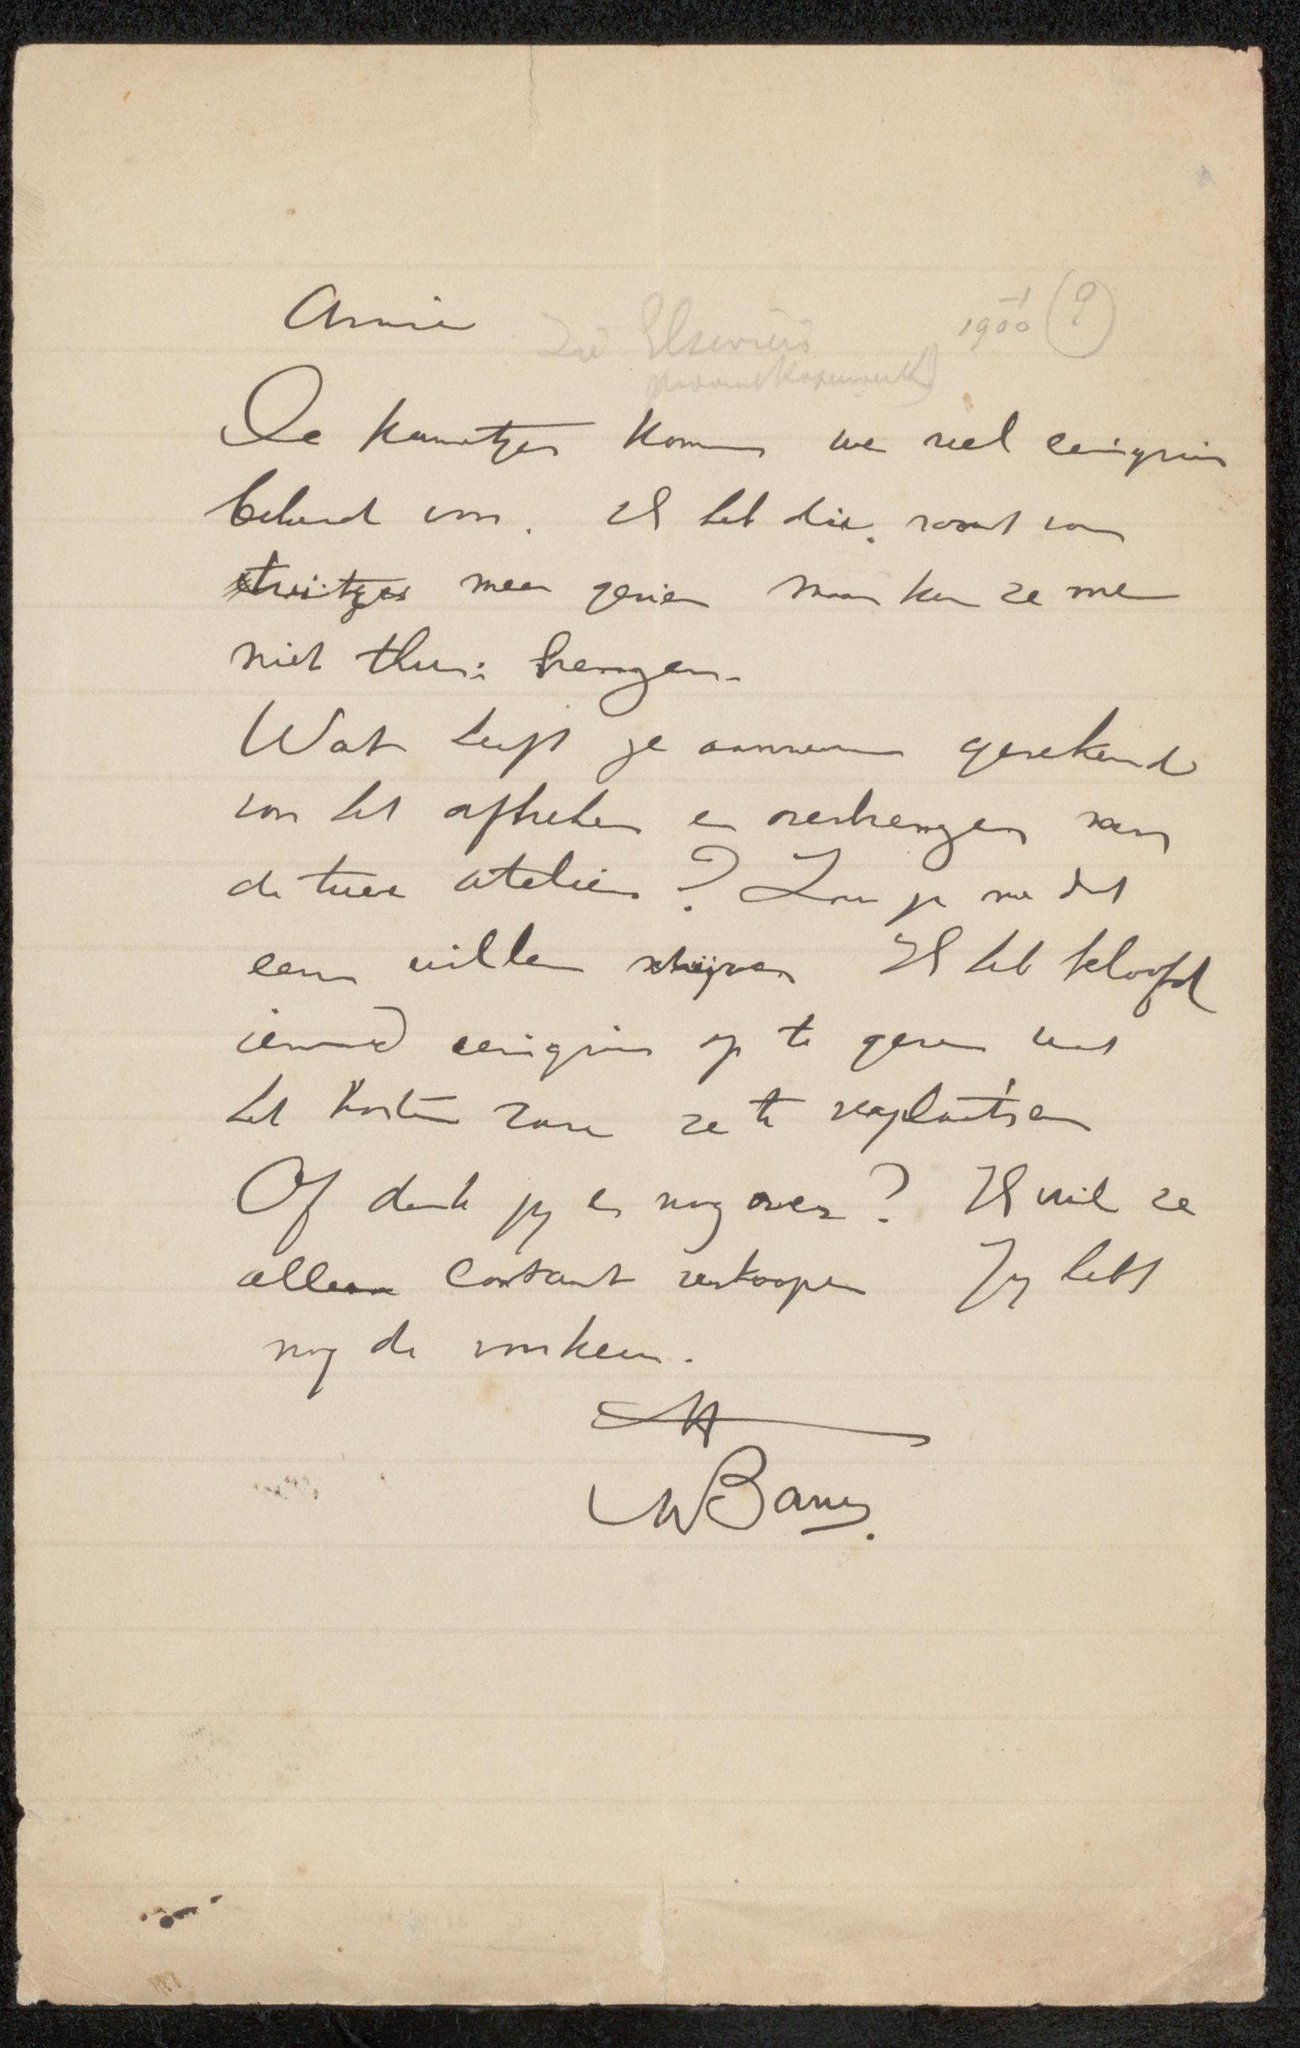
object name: letter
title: Brief aan Philip Zilcken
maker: marius bauer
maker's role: draughtsman, print maker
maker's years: 1867-1932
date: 1877-1932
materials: ink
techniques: pen, writing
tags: painter, philip zilcken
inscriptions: collector's mark: ‘RPK’